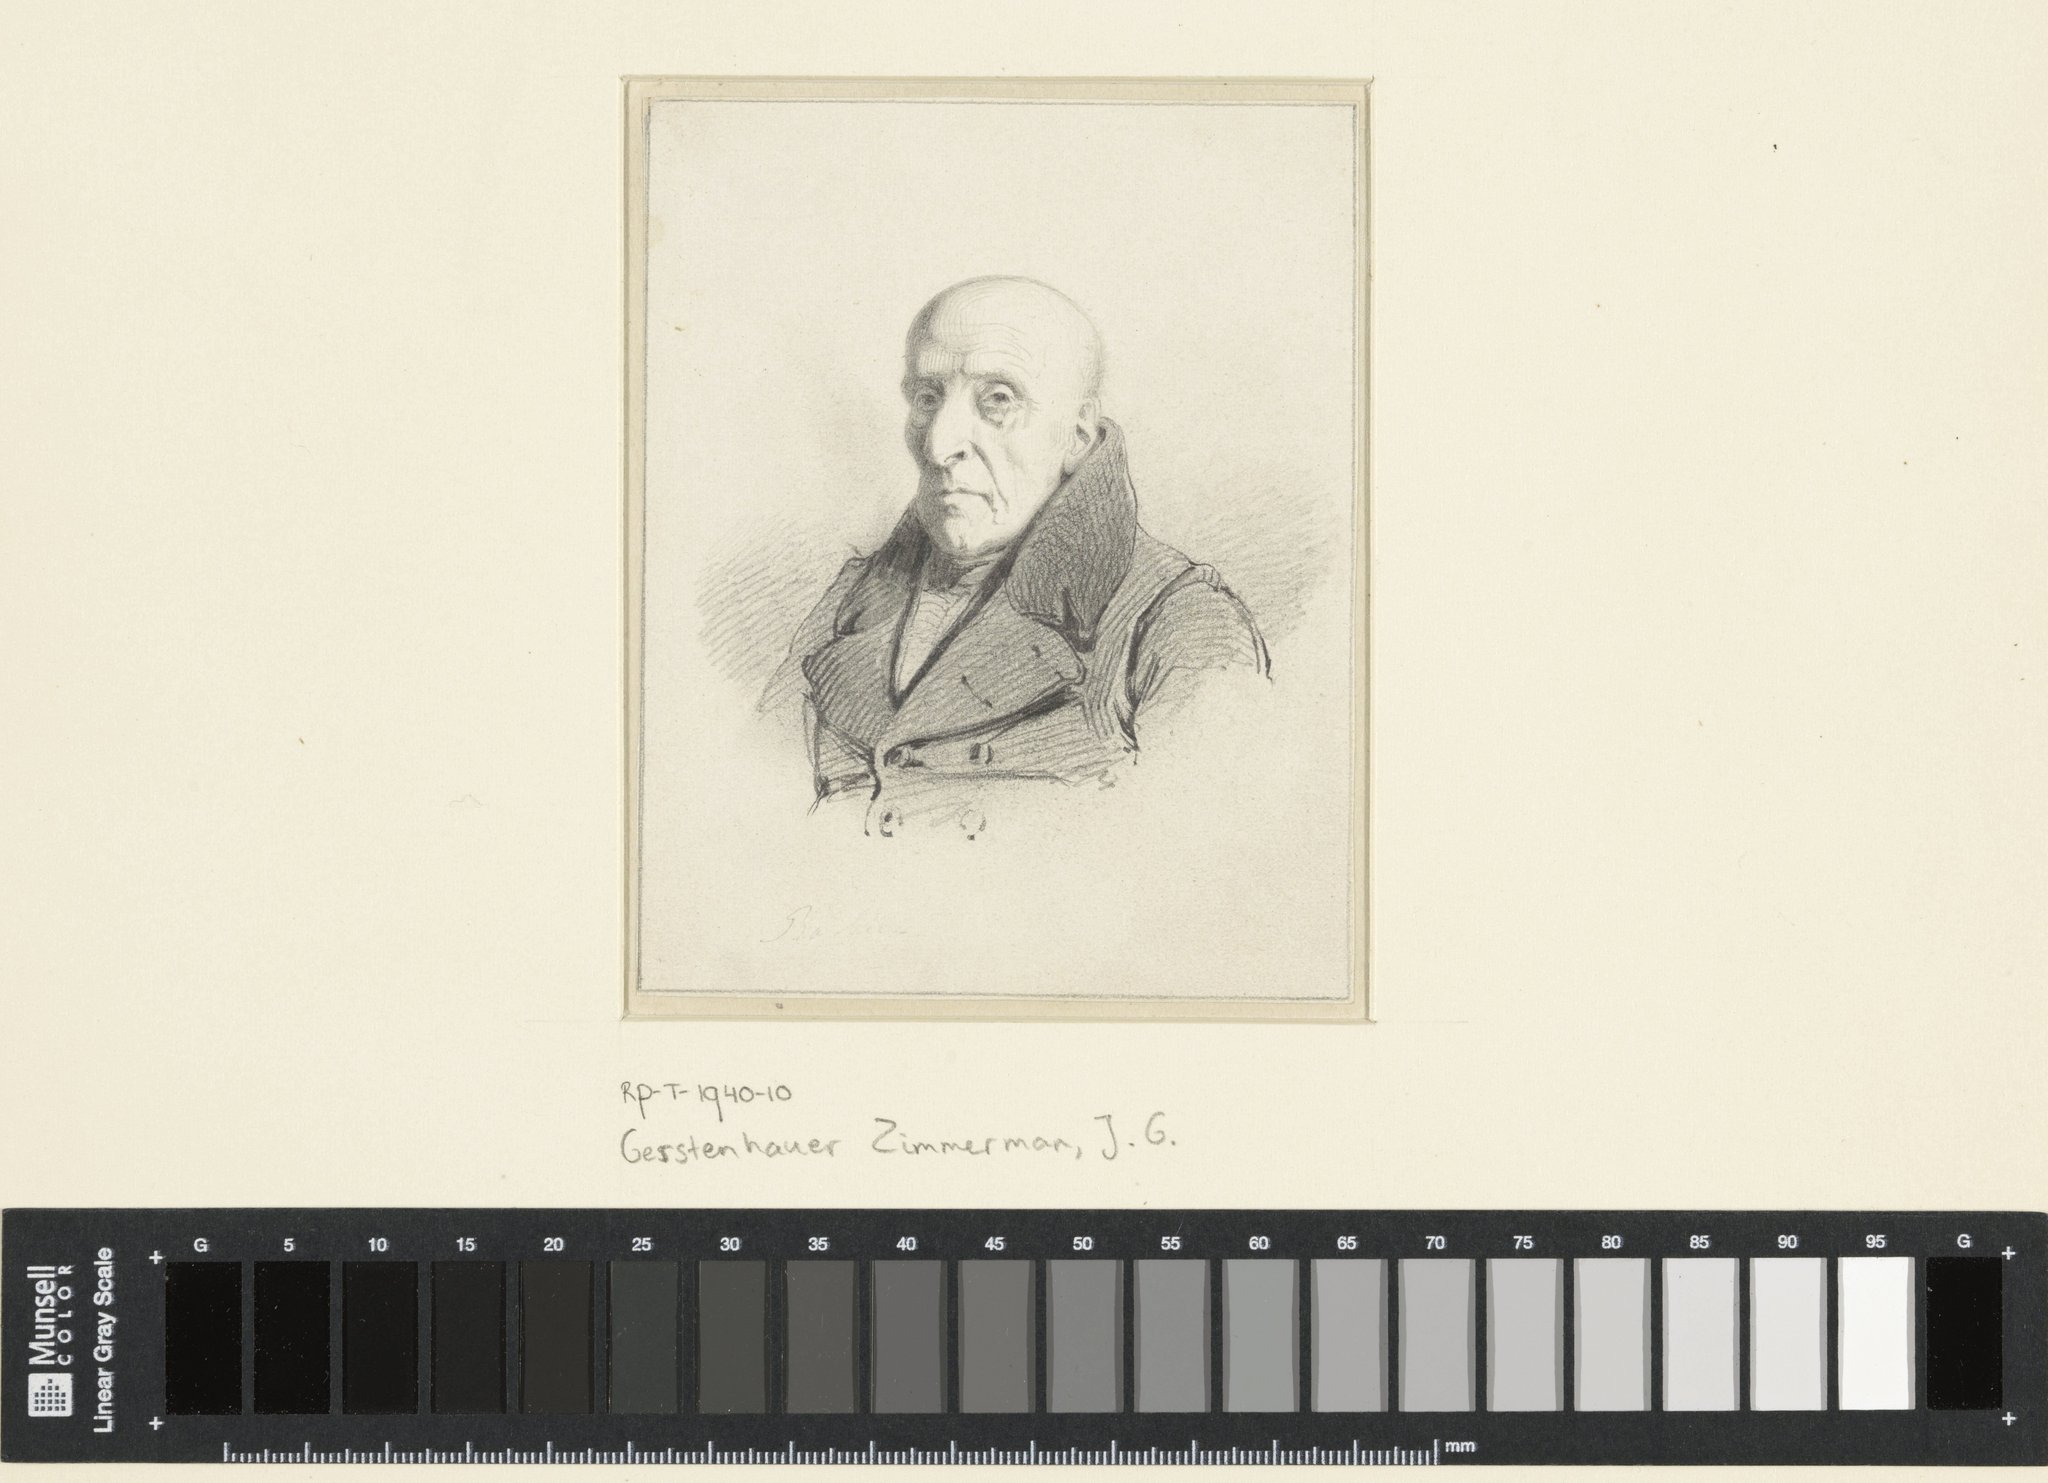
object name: drawing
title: Portret van Pieter Pzn Barbiers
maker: johan georg gerstenhauer zimmerman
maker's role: draughtsman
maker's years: 1858-1931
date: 1868-1931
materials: chalk, paper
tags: pieter pietersz. barbiers, historical persons, portrait, self-portrait of painter, portrait, self-portrait of artist, portrait, self-portrait of draughtsman